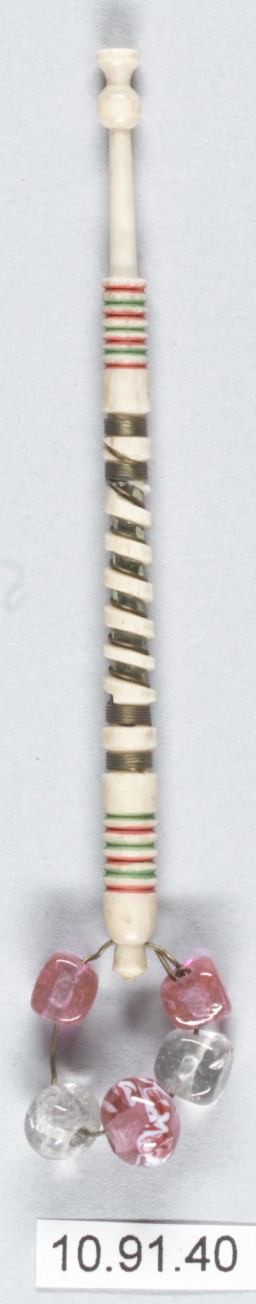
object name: bobbin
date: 1801-1900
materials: bone, metal